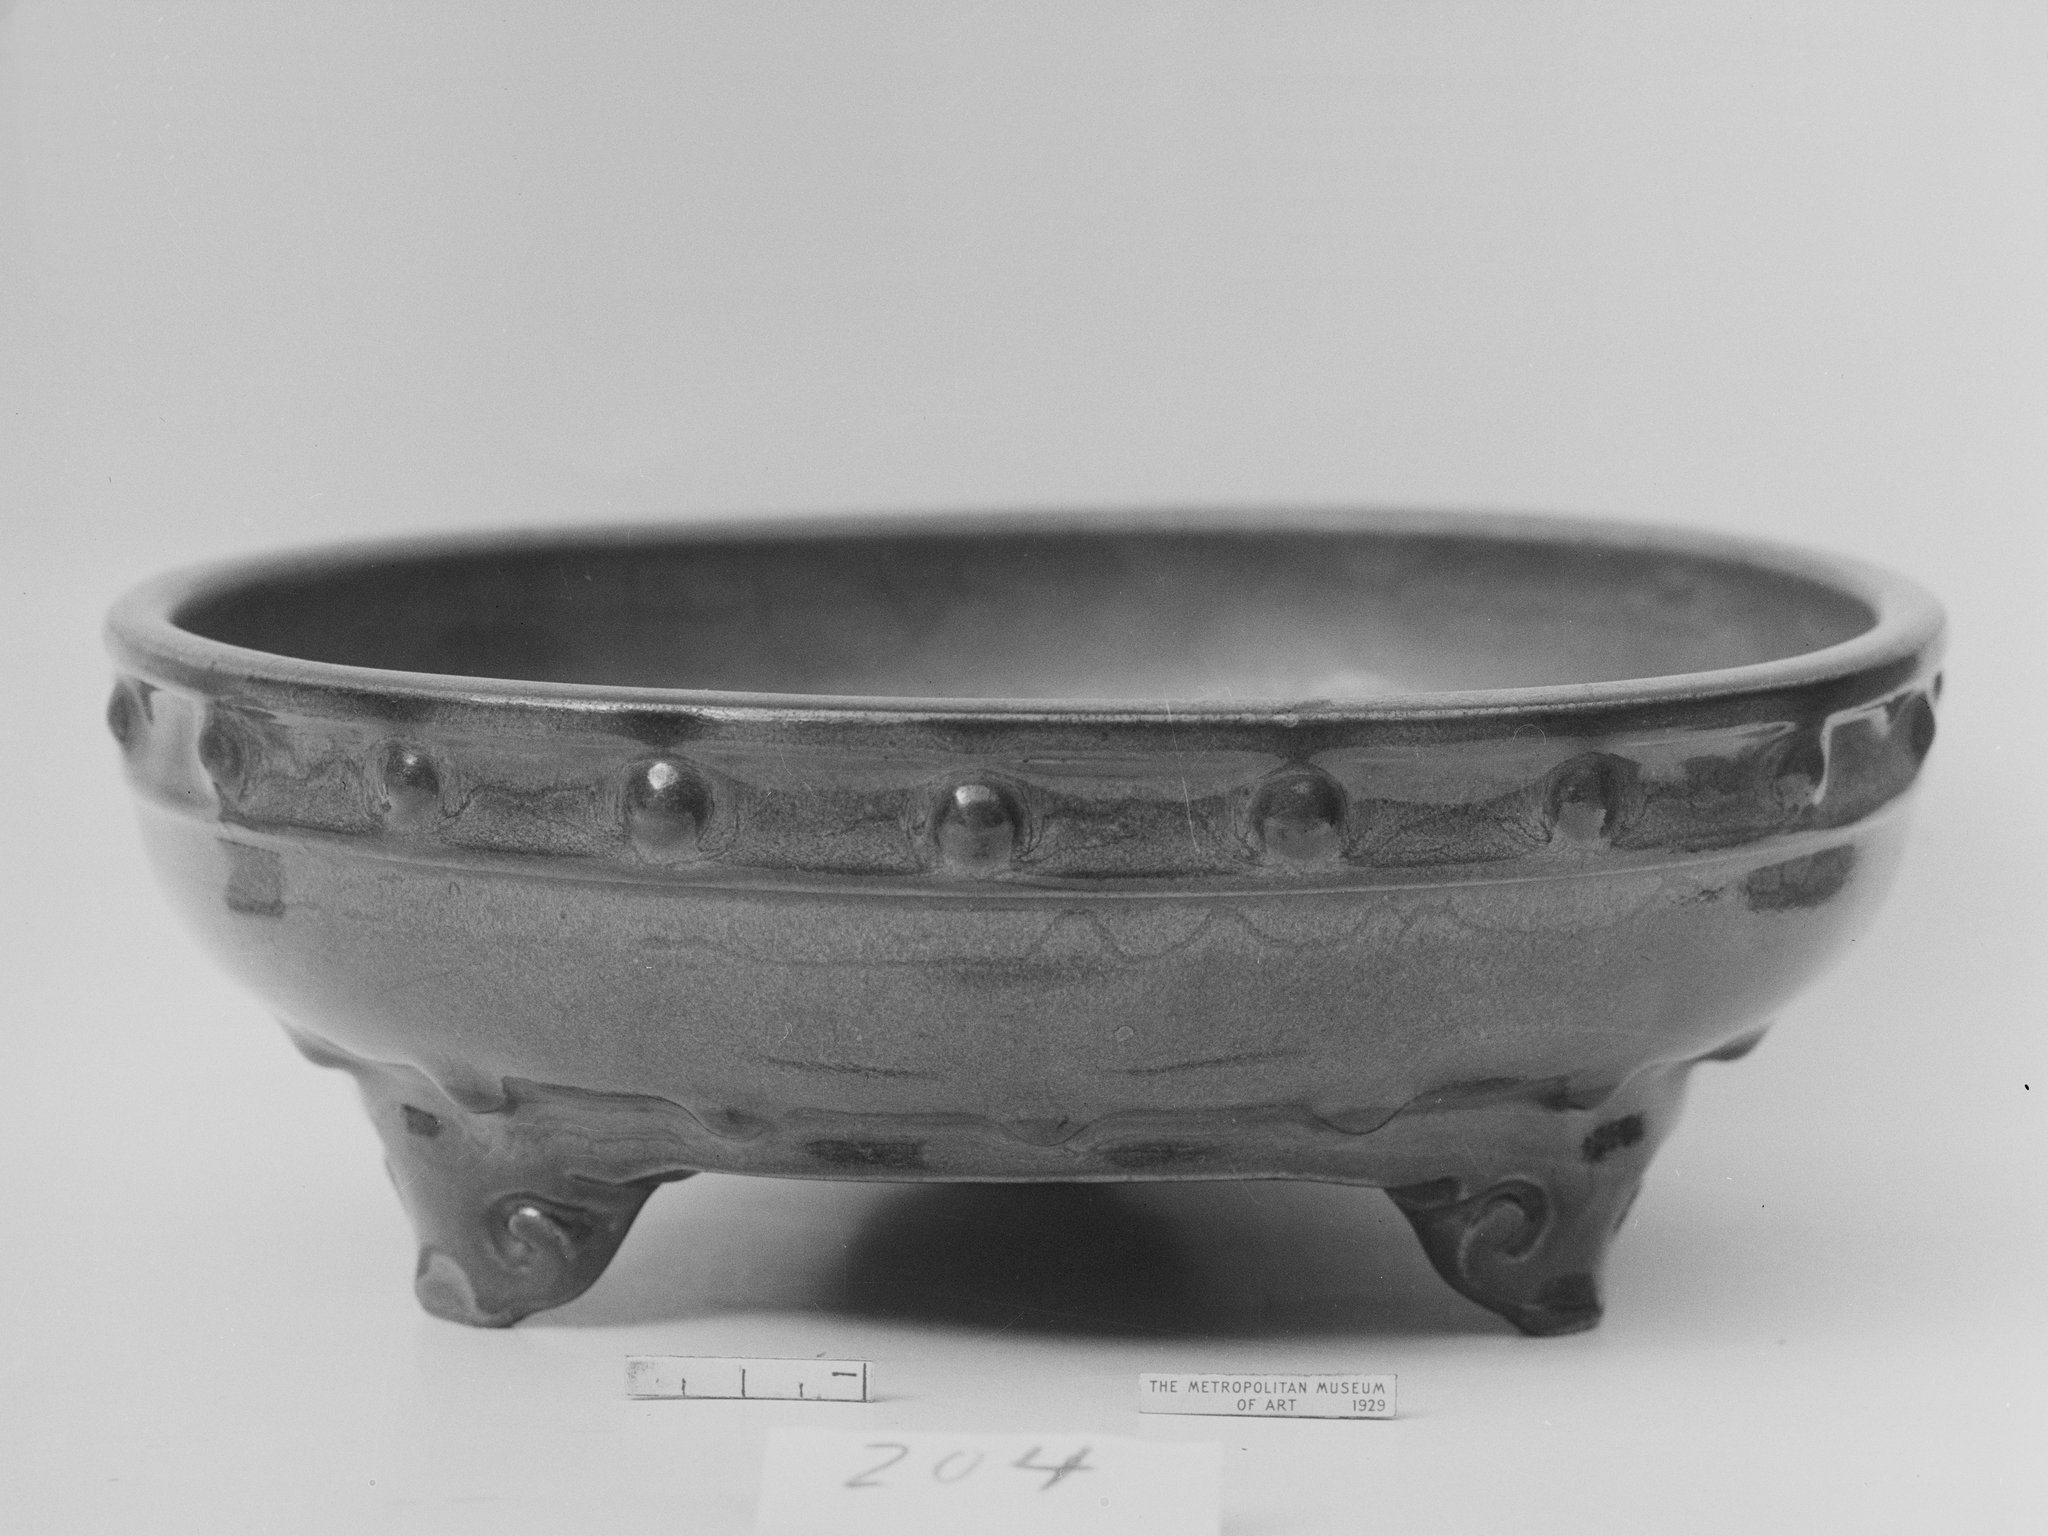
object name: bowl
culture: chinese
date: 960-1279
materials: pottery